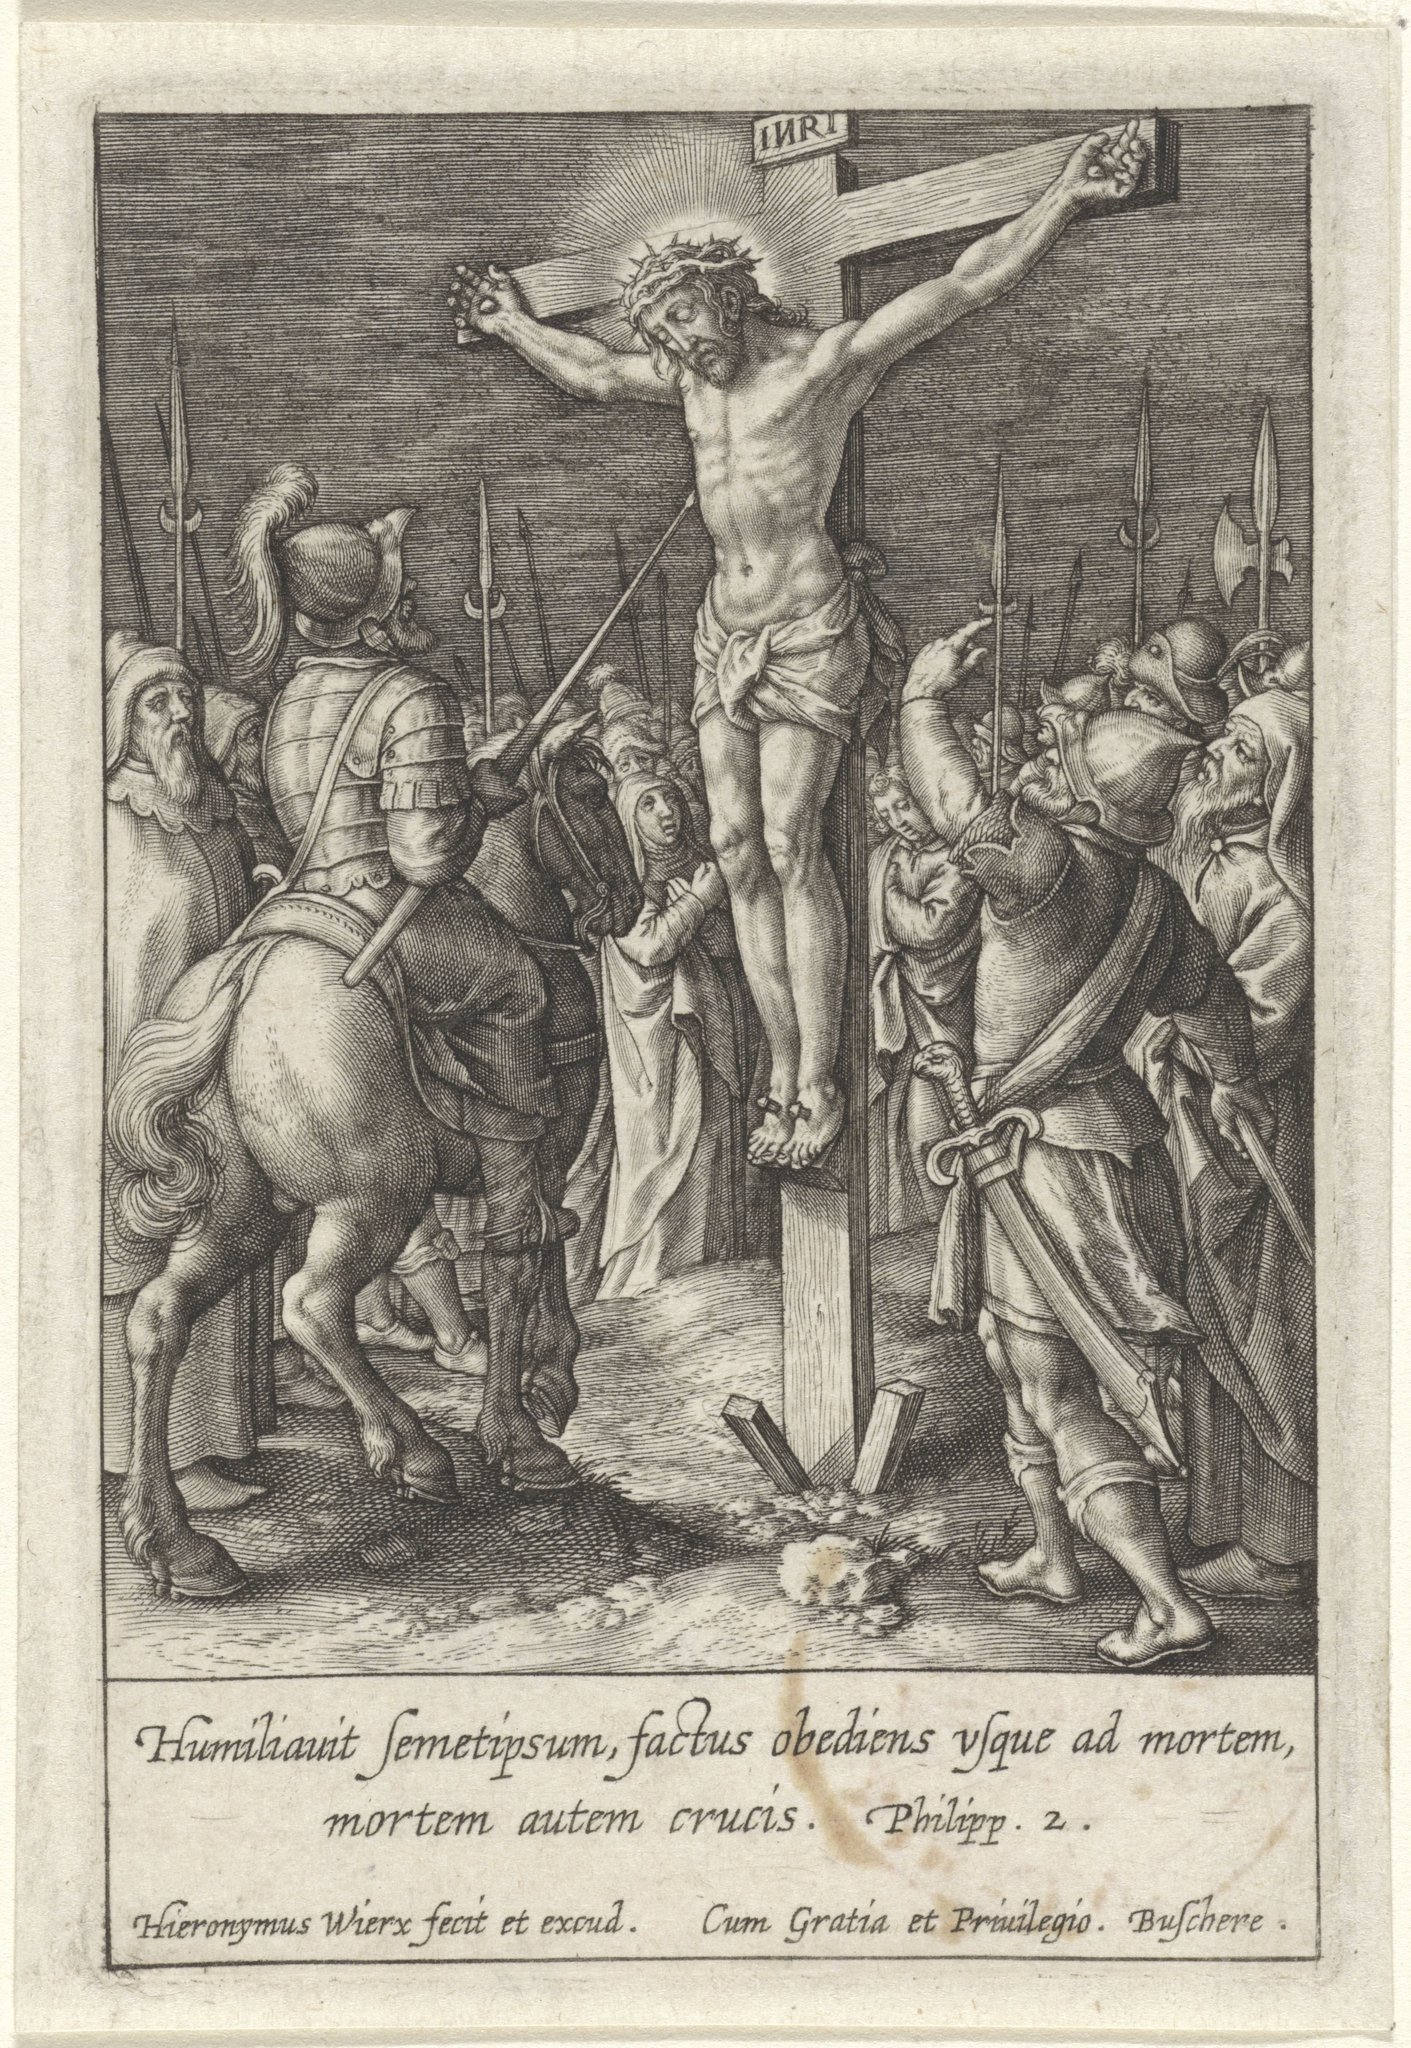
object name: print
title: Passie van Christus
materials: paper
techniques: engraving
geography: antwerp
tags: longinus pierces christ's side with a lance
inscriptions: collector's mark: Lugt 240, number: ‘60’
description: Kruisdood van Christus op Golgota. Longinus steekt zijn lans in de zij van Christus. In de marge een tweeregelig Bijbelcitaat uit Fil. 2 in het Latijn.